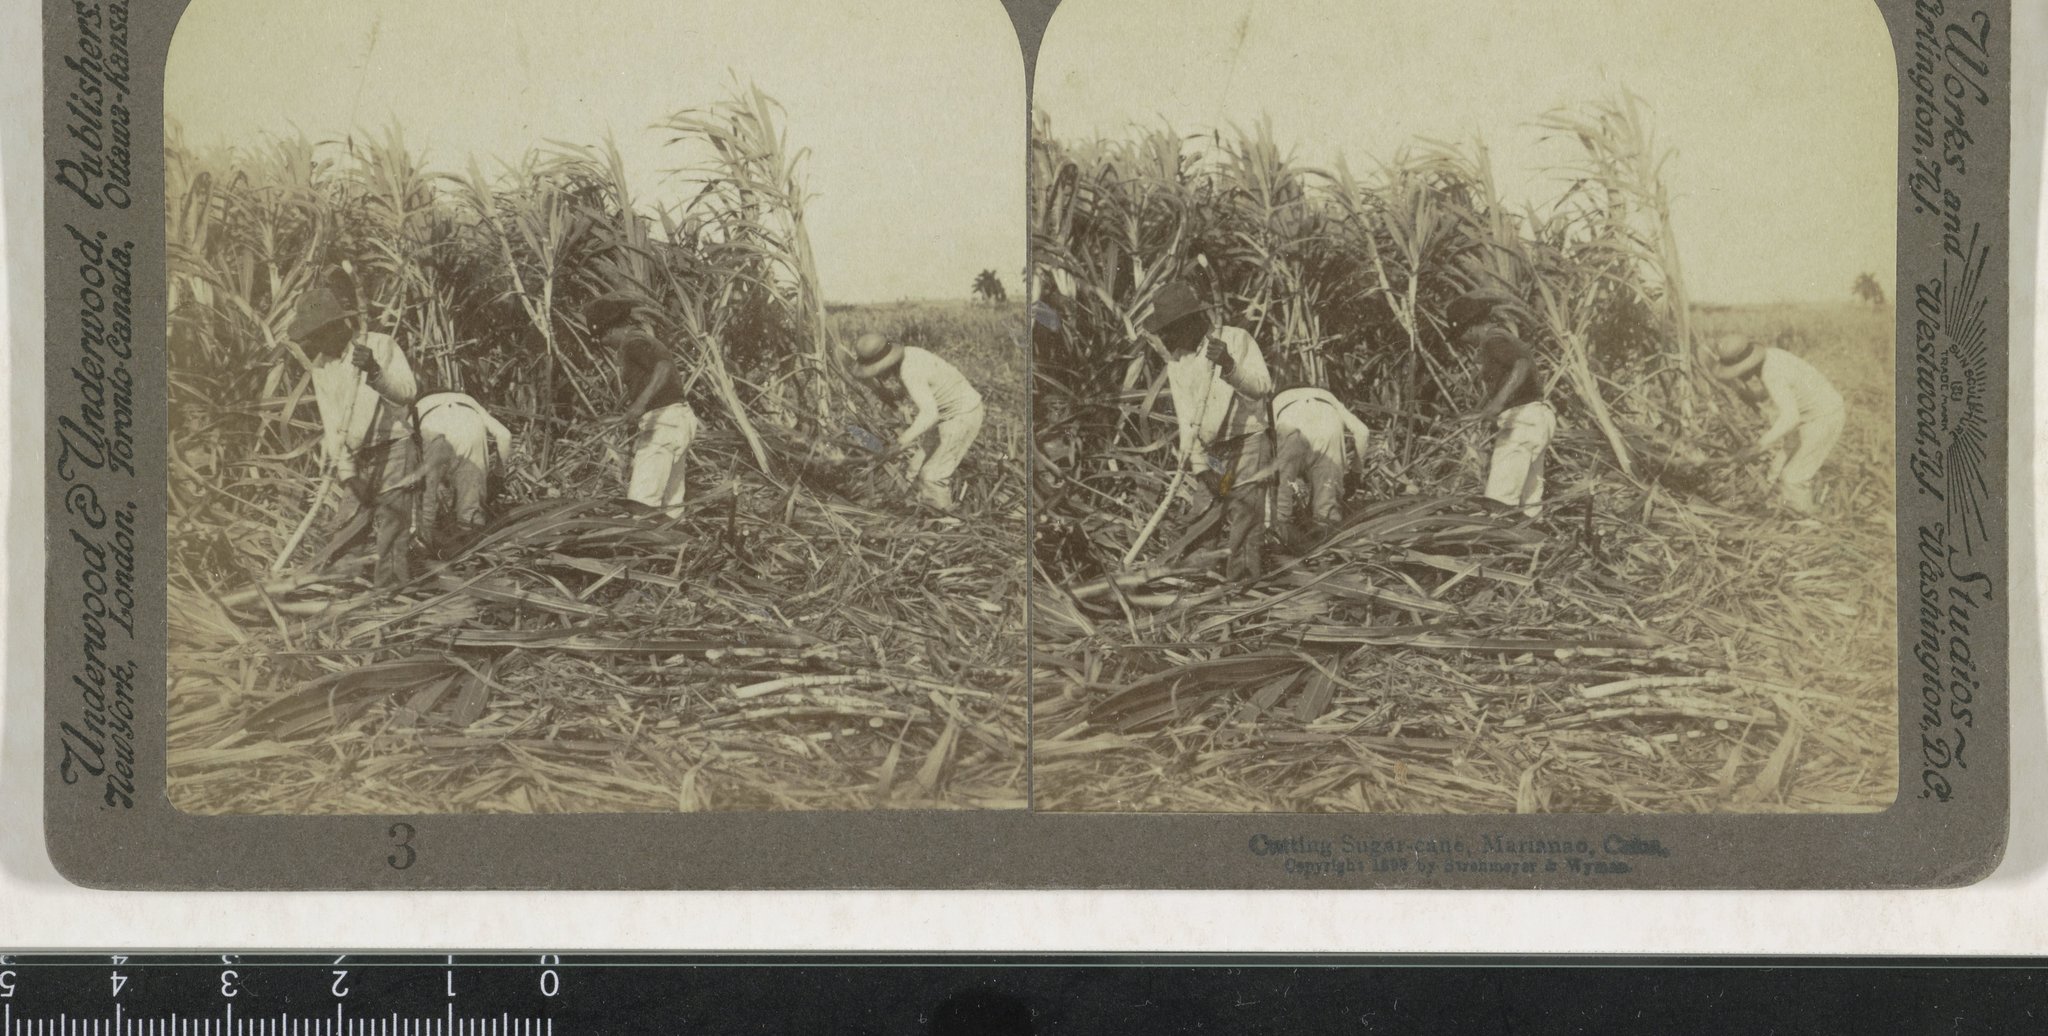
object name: stereograph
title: Veldarbeiders oogsten suikerriet in Marianao, Havana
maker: Anonymous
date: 1899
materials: cardboard, paper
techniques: albumen print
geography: new york city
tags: reaping, picking, mowing ~ harvest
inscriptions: number: ‘N 8’, copyright notice: ‘Copyright 1899 by Strohmeyer & Wyman.’, title: ‘Cutting sugar-cane, Marianao, Cuba.’, inscription: ‘SUN SCULPTURE/ UU/ TRADEMARK/ Works and Studios/ Arlington, N.J. Westwood, N.J. Washington, D.C.’, number: ‘3’